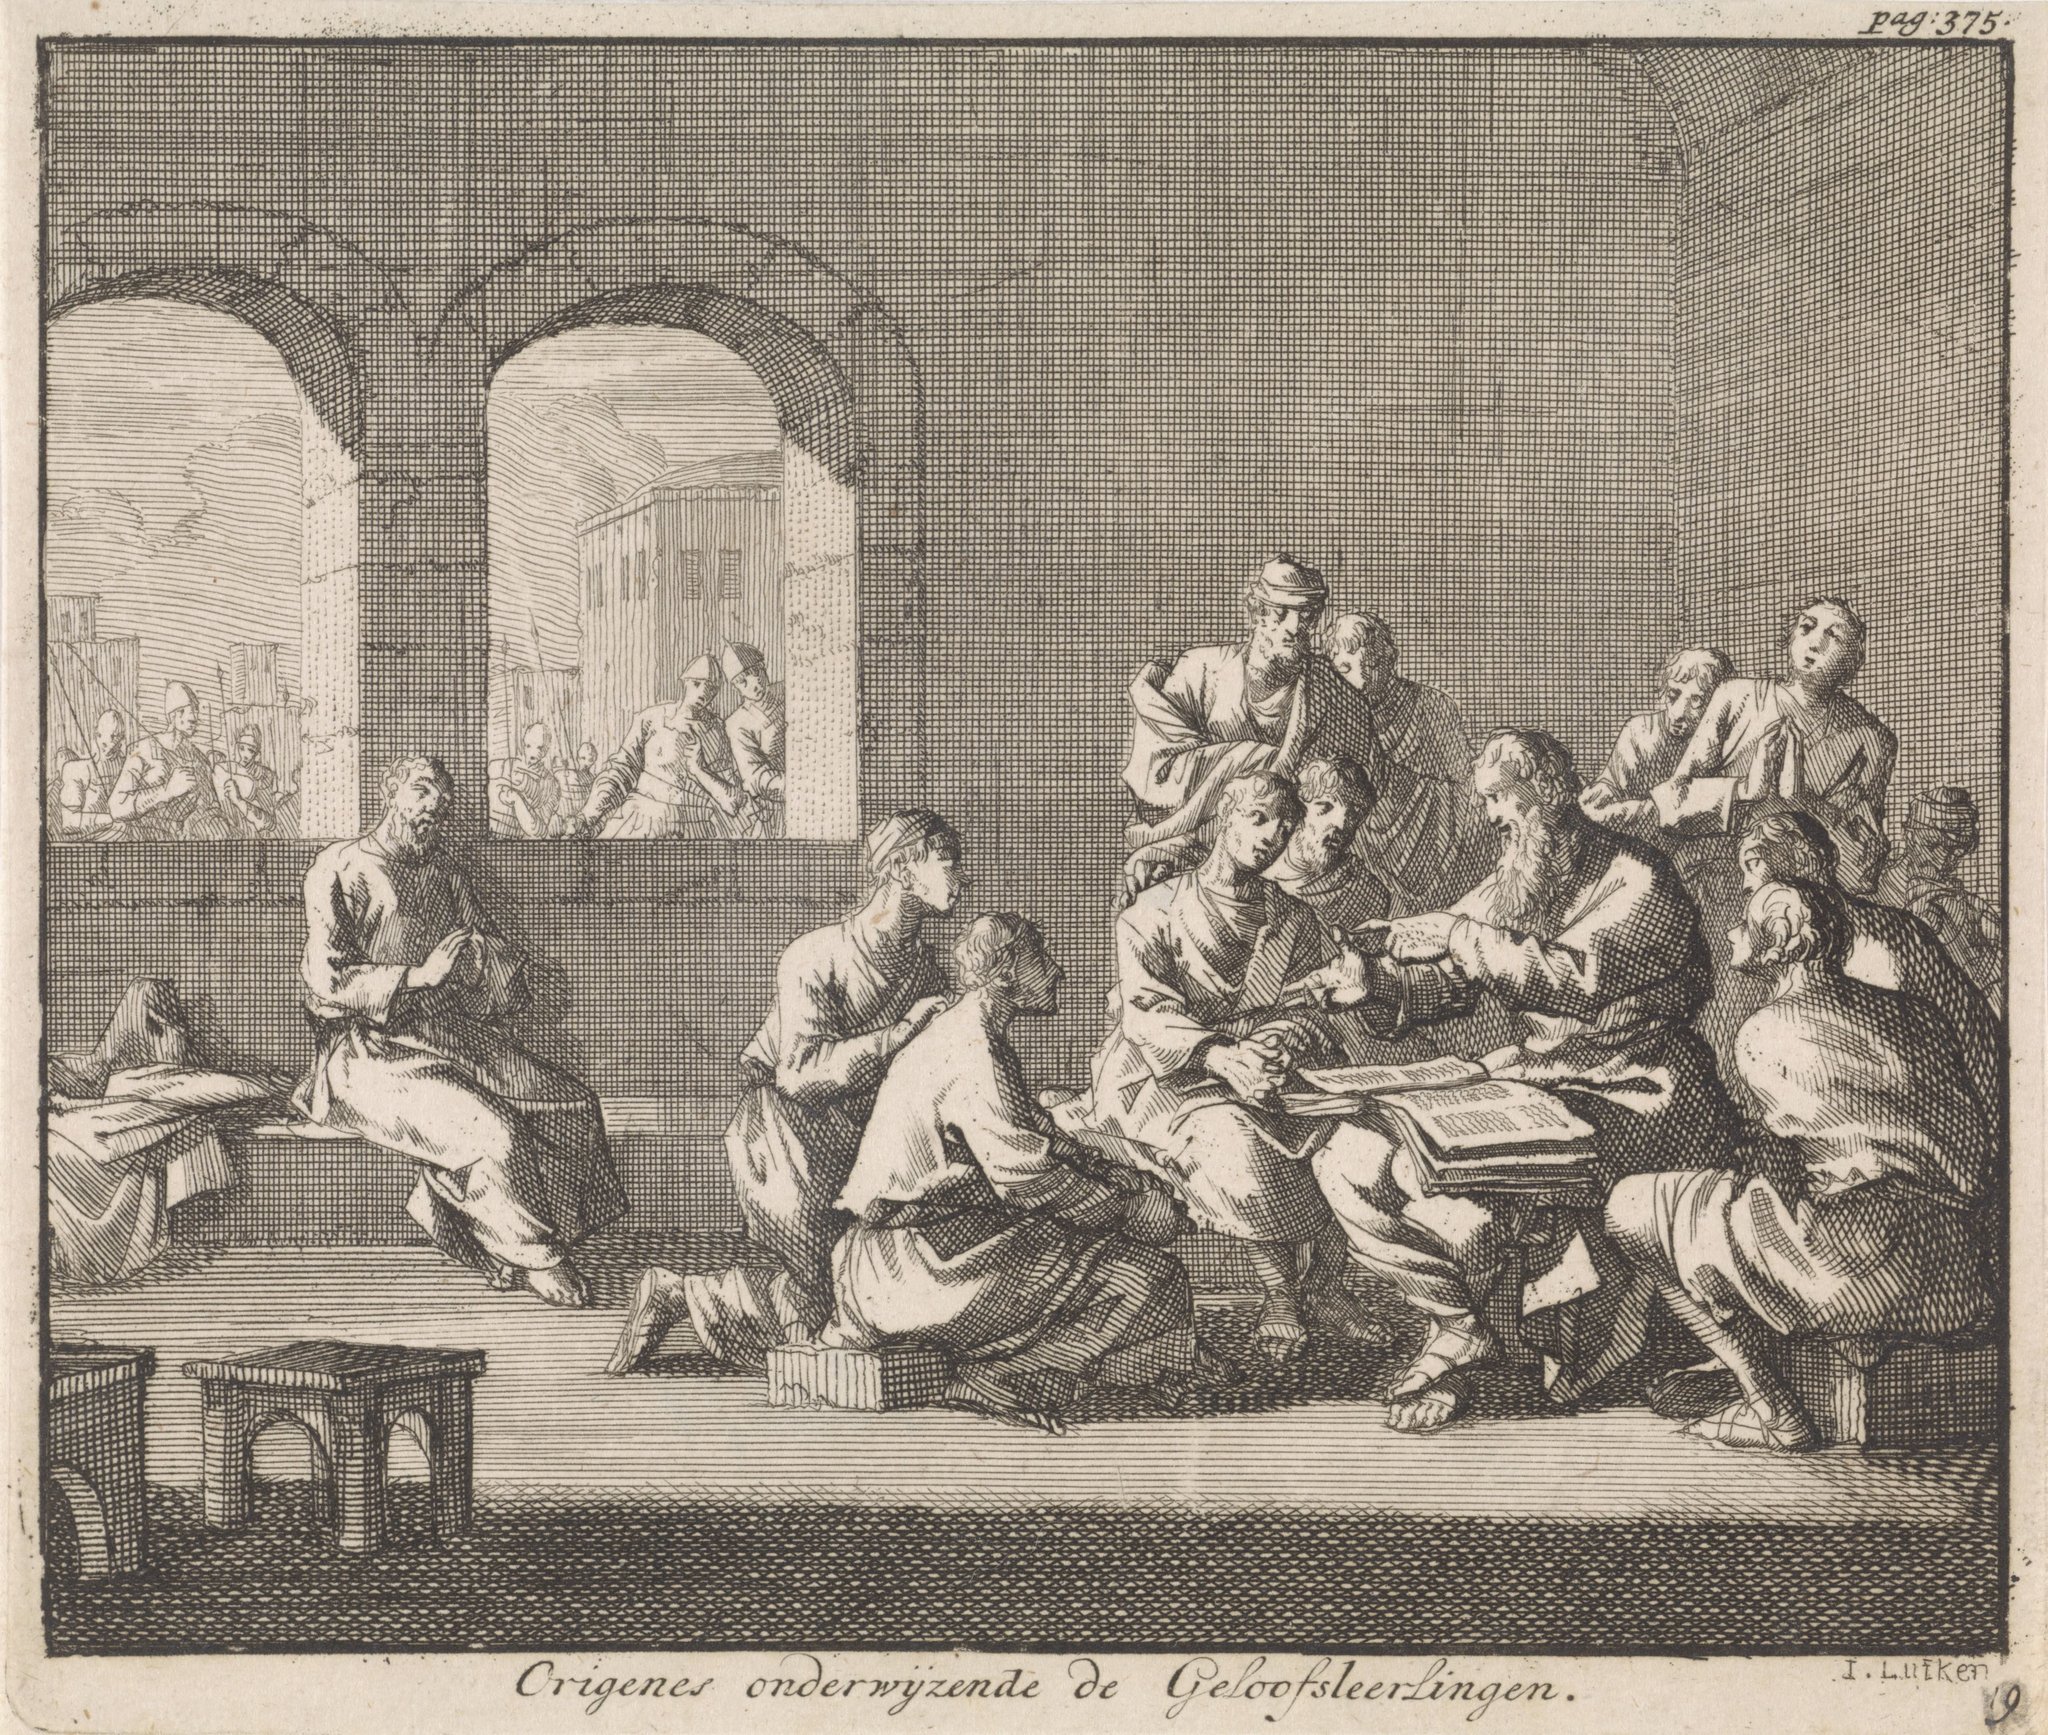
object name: print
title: Origenes onderwijzende de Geloofsleerlingen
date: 1700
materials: paper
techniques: etching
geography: amsterdam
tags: catechism, the early christian churches, e.g. armenians, copts, syrians, religious instruction of laity, e.g. sunday school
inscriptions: collector's mark: Lugt 2228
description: Boekillustratie voor Arnold, Godfried. Waare afbeelding der eerste christenen. Amsterdam: Jacobus van Hardenberg, Barent Visscher en Jacobus van Nieuweveen, 1700, dl. 1, p. 375.